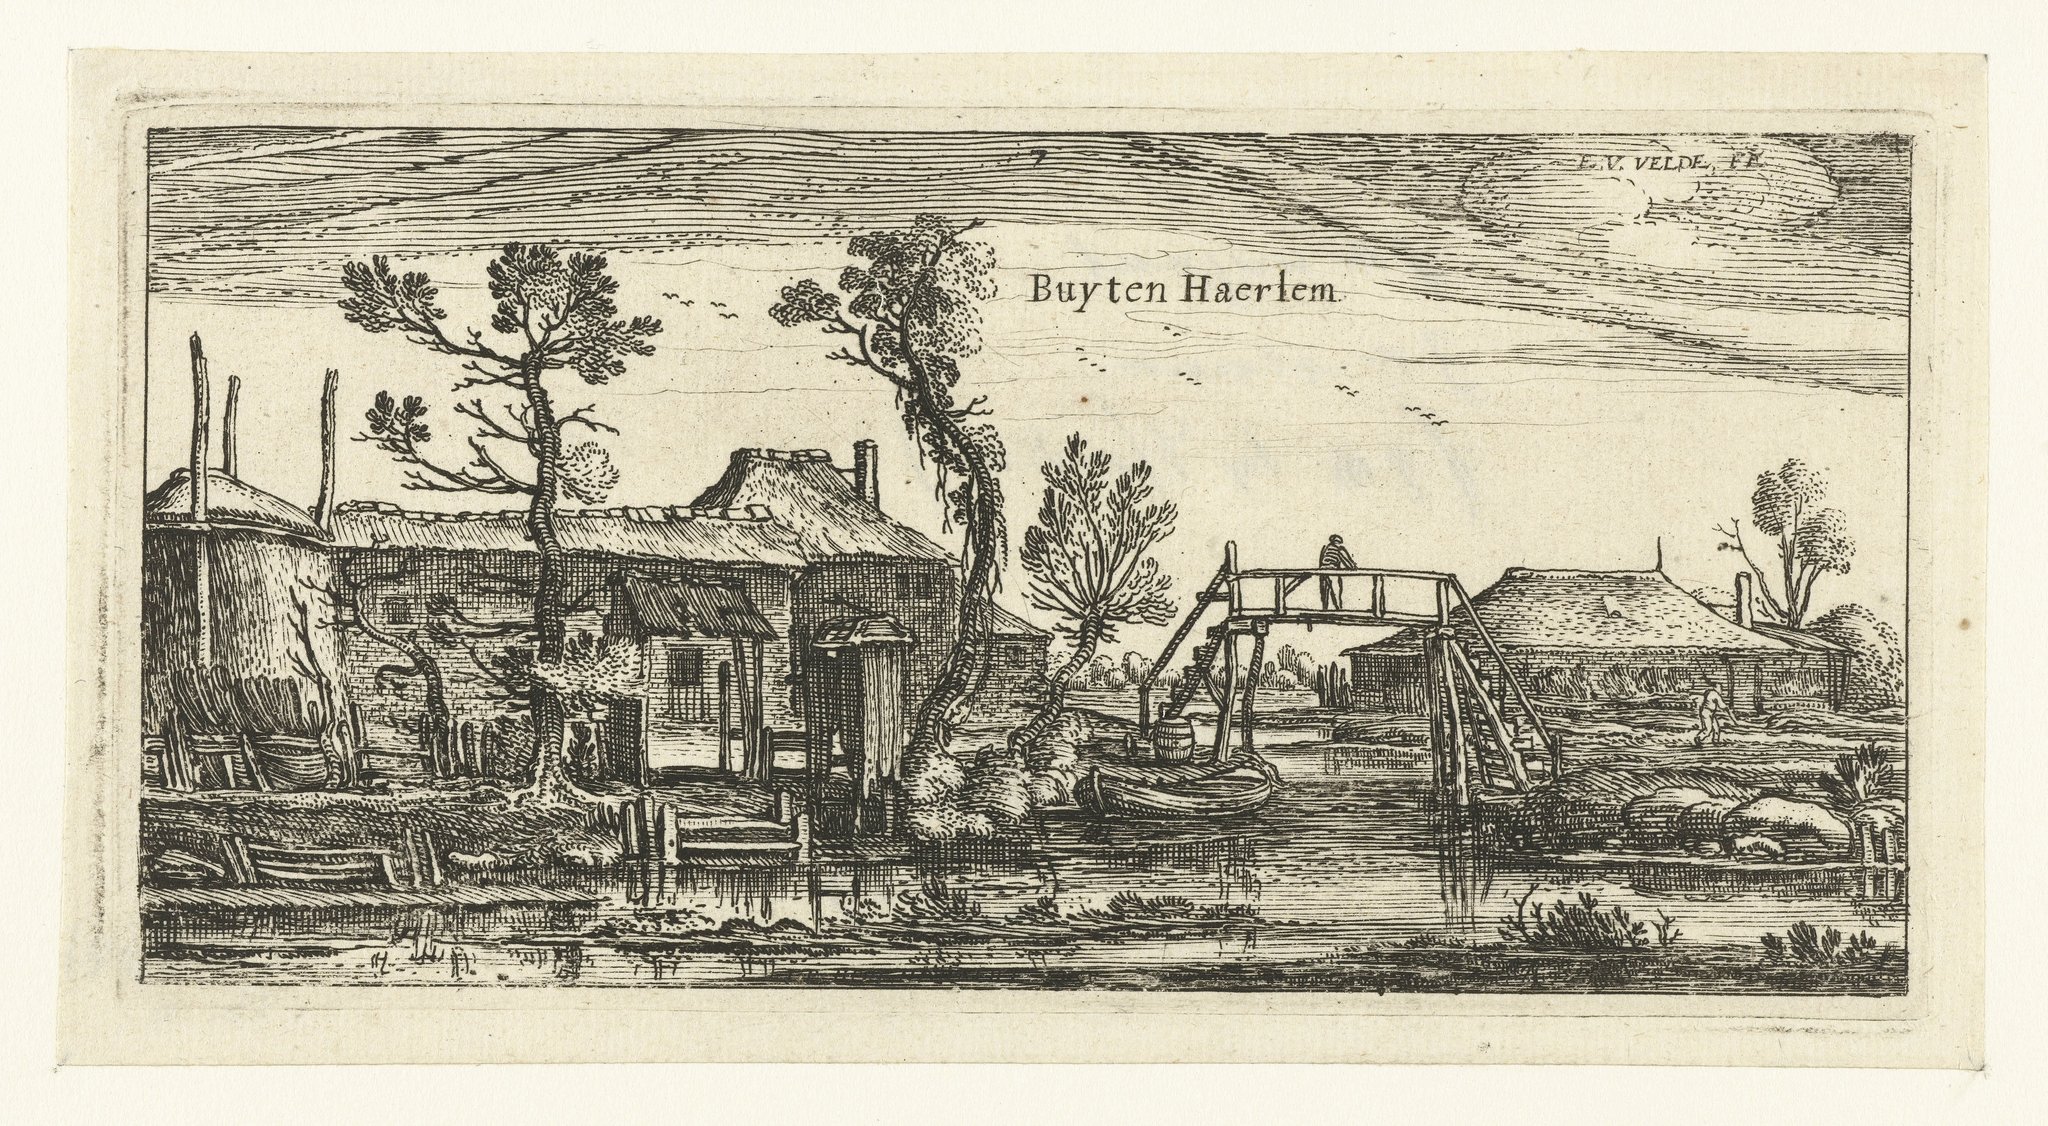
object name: print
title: Landschappen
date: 1614-1616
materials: paper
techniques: engraving, etching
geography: haarlem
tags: farm or solitary house in landscape, haarlem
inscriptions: collector's mark: Lugt 2228a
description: Op de tweede uitgave van de prentserie Landschappen voegde Hendrik Hondius een plaatsaanduiding toe. Dit landschap met een boerderij ligt volgens het opschrift Buyten Haerlem.